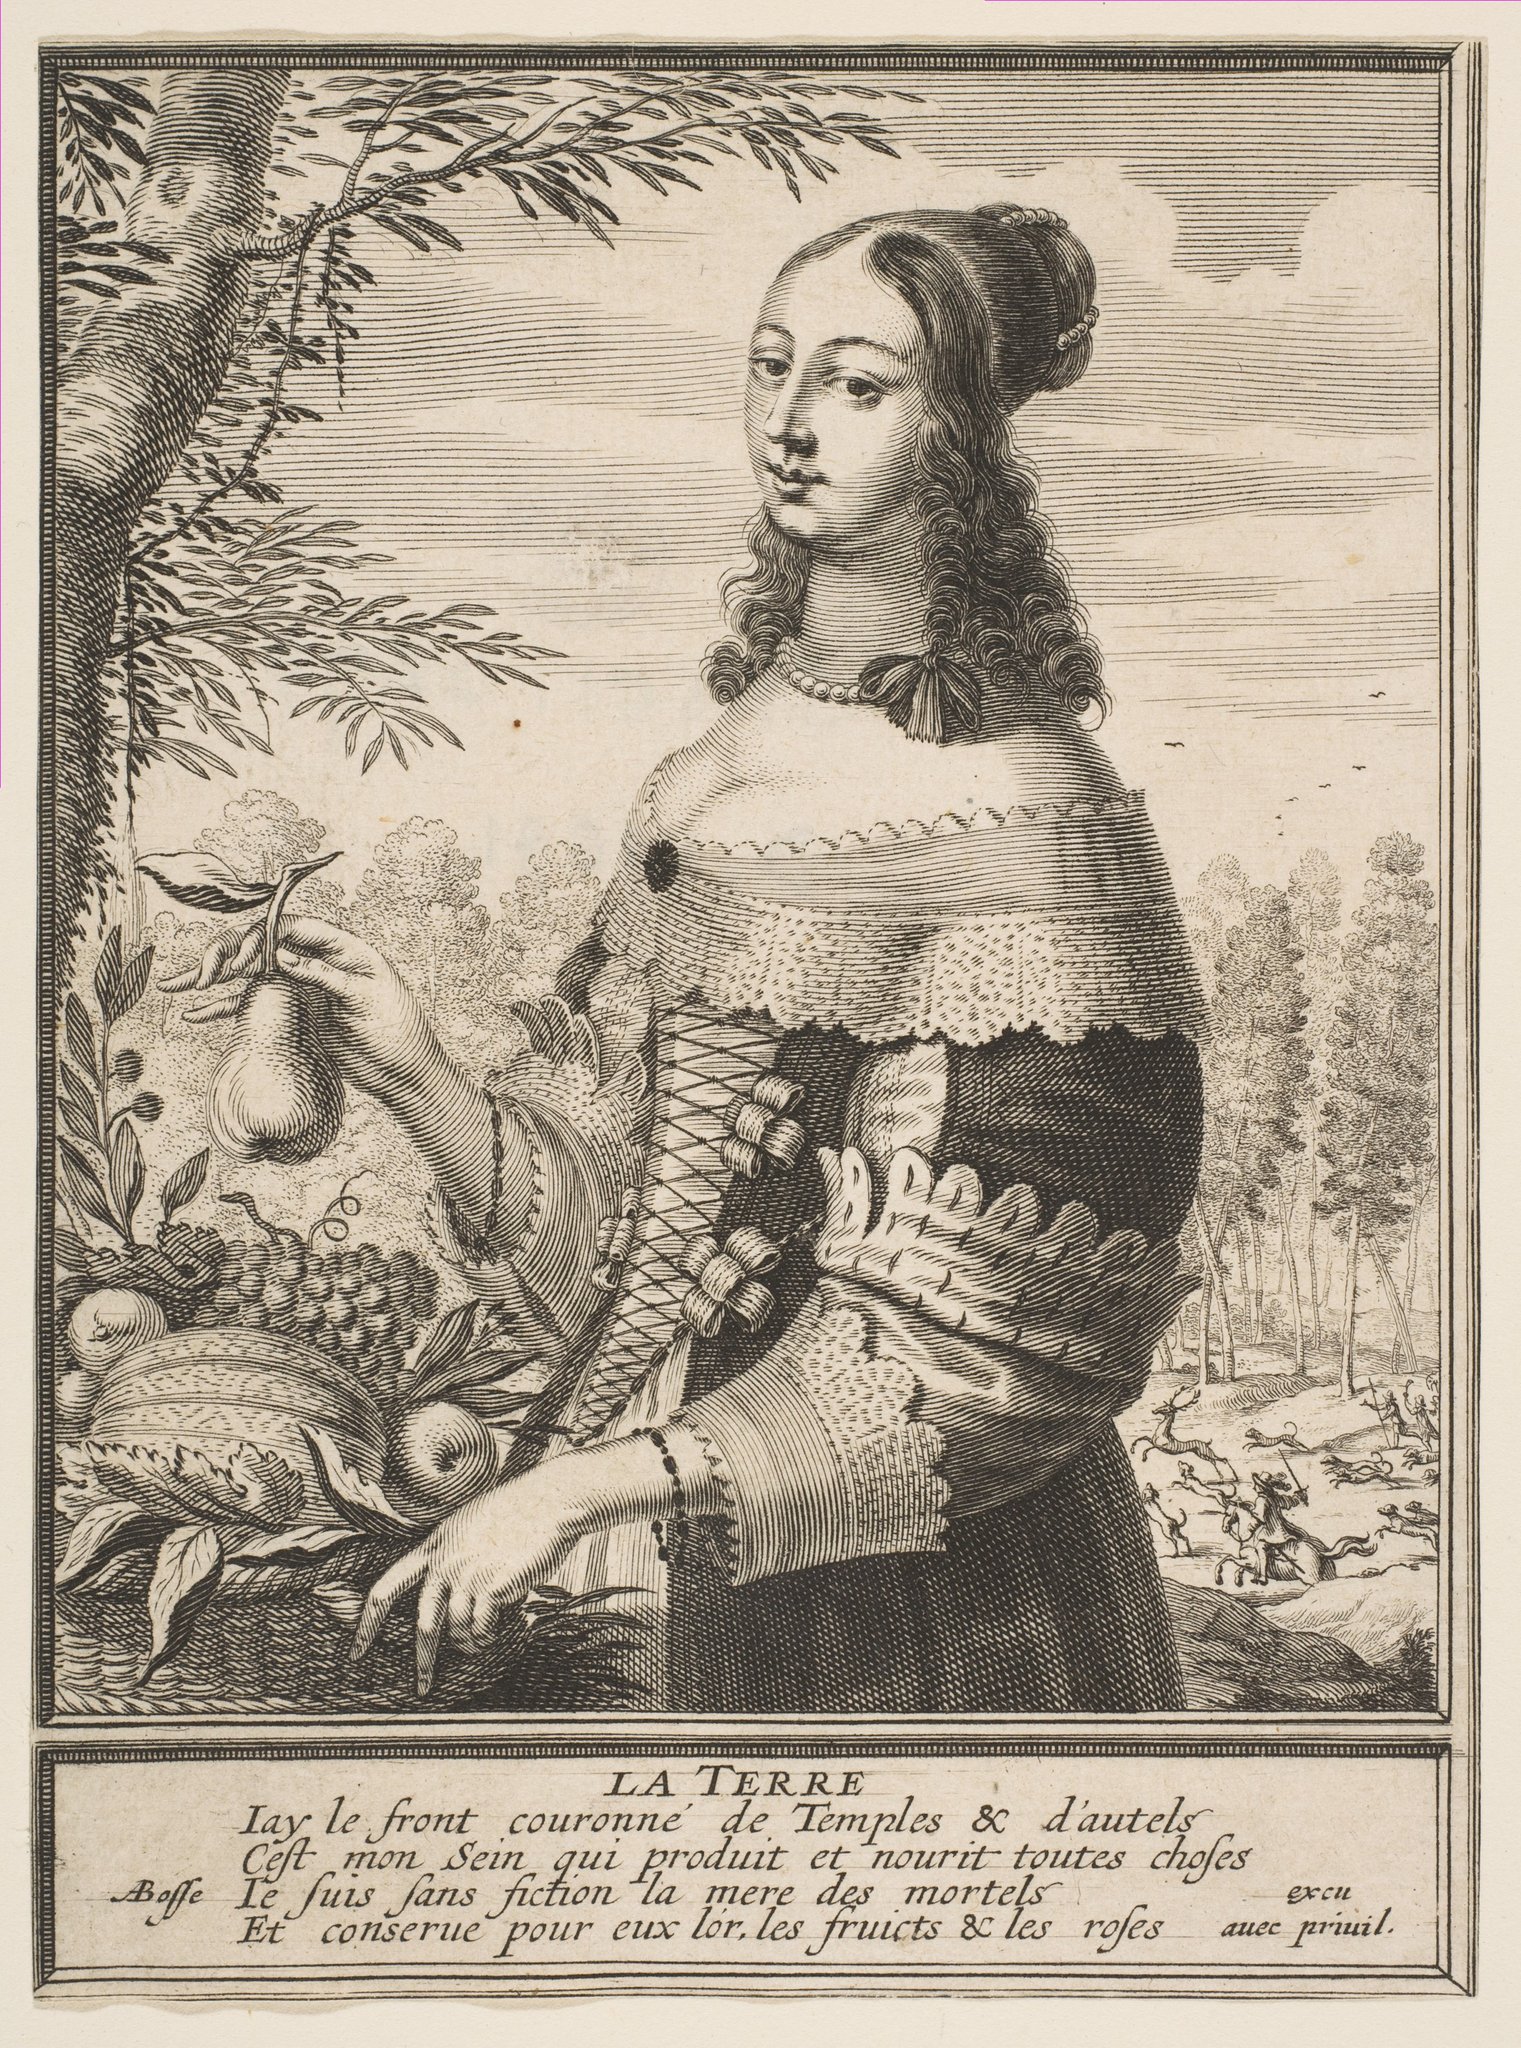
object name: print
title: Earth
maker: abraham bosse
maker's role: artist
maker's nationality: french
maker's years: 1602-1676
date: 1630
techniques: etching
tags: fruit,women,deer